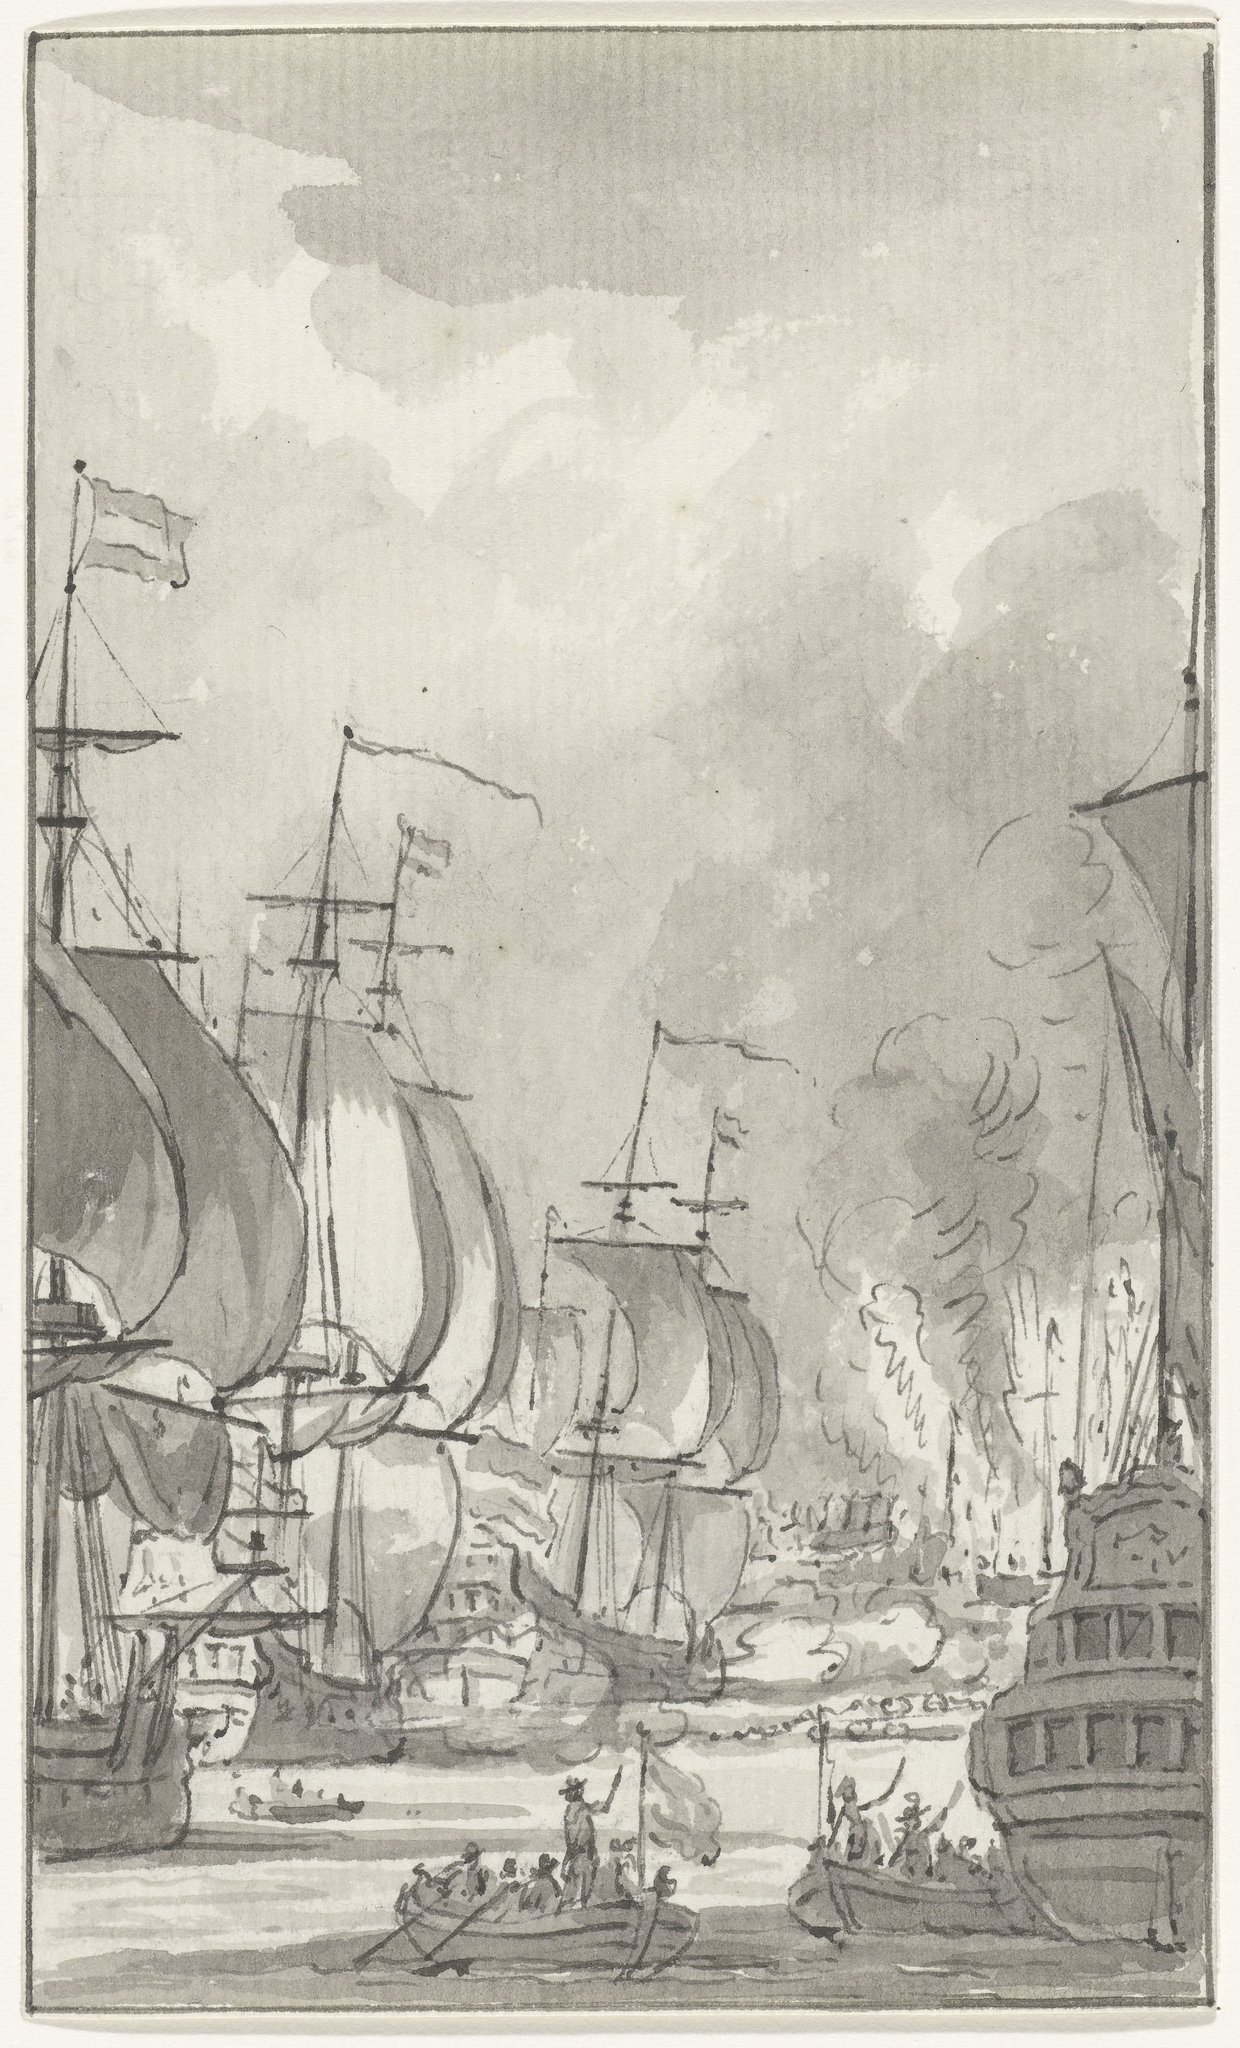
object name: drawing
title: Het overvaren van de ketting in de Medway, 1667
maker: jacobus buys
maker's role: draughtsman, print maker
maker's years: 1724-1801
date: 1788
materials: ink, paper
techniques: brush, pen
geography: northern netherlands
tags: battle (+ naval force), raid on the medway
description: Het overvaren van de ketting in de Medway door kapitein Jan van Brakel met zijn schip de Vreede en de branders Suzanna en Pro Patria, 22 juni 1667. Episode uit de Tocht naar Chatham en de vernietiging van de Engelse vloot op 20-23 juni 1667 door de Staatse vloot onder De Ruyter.